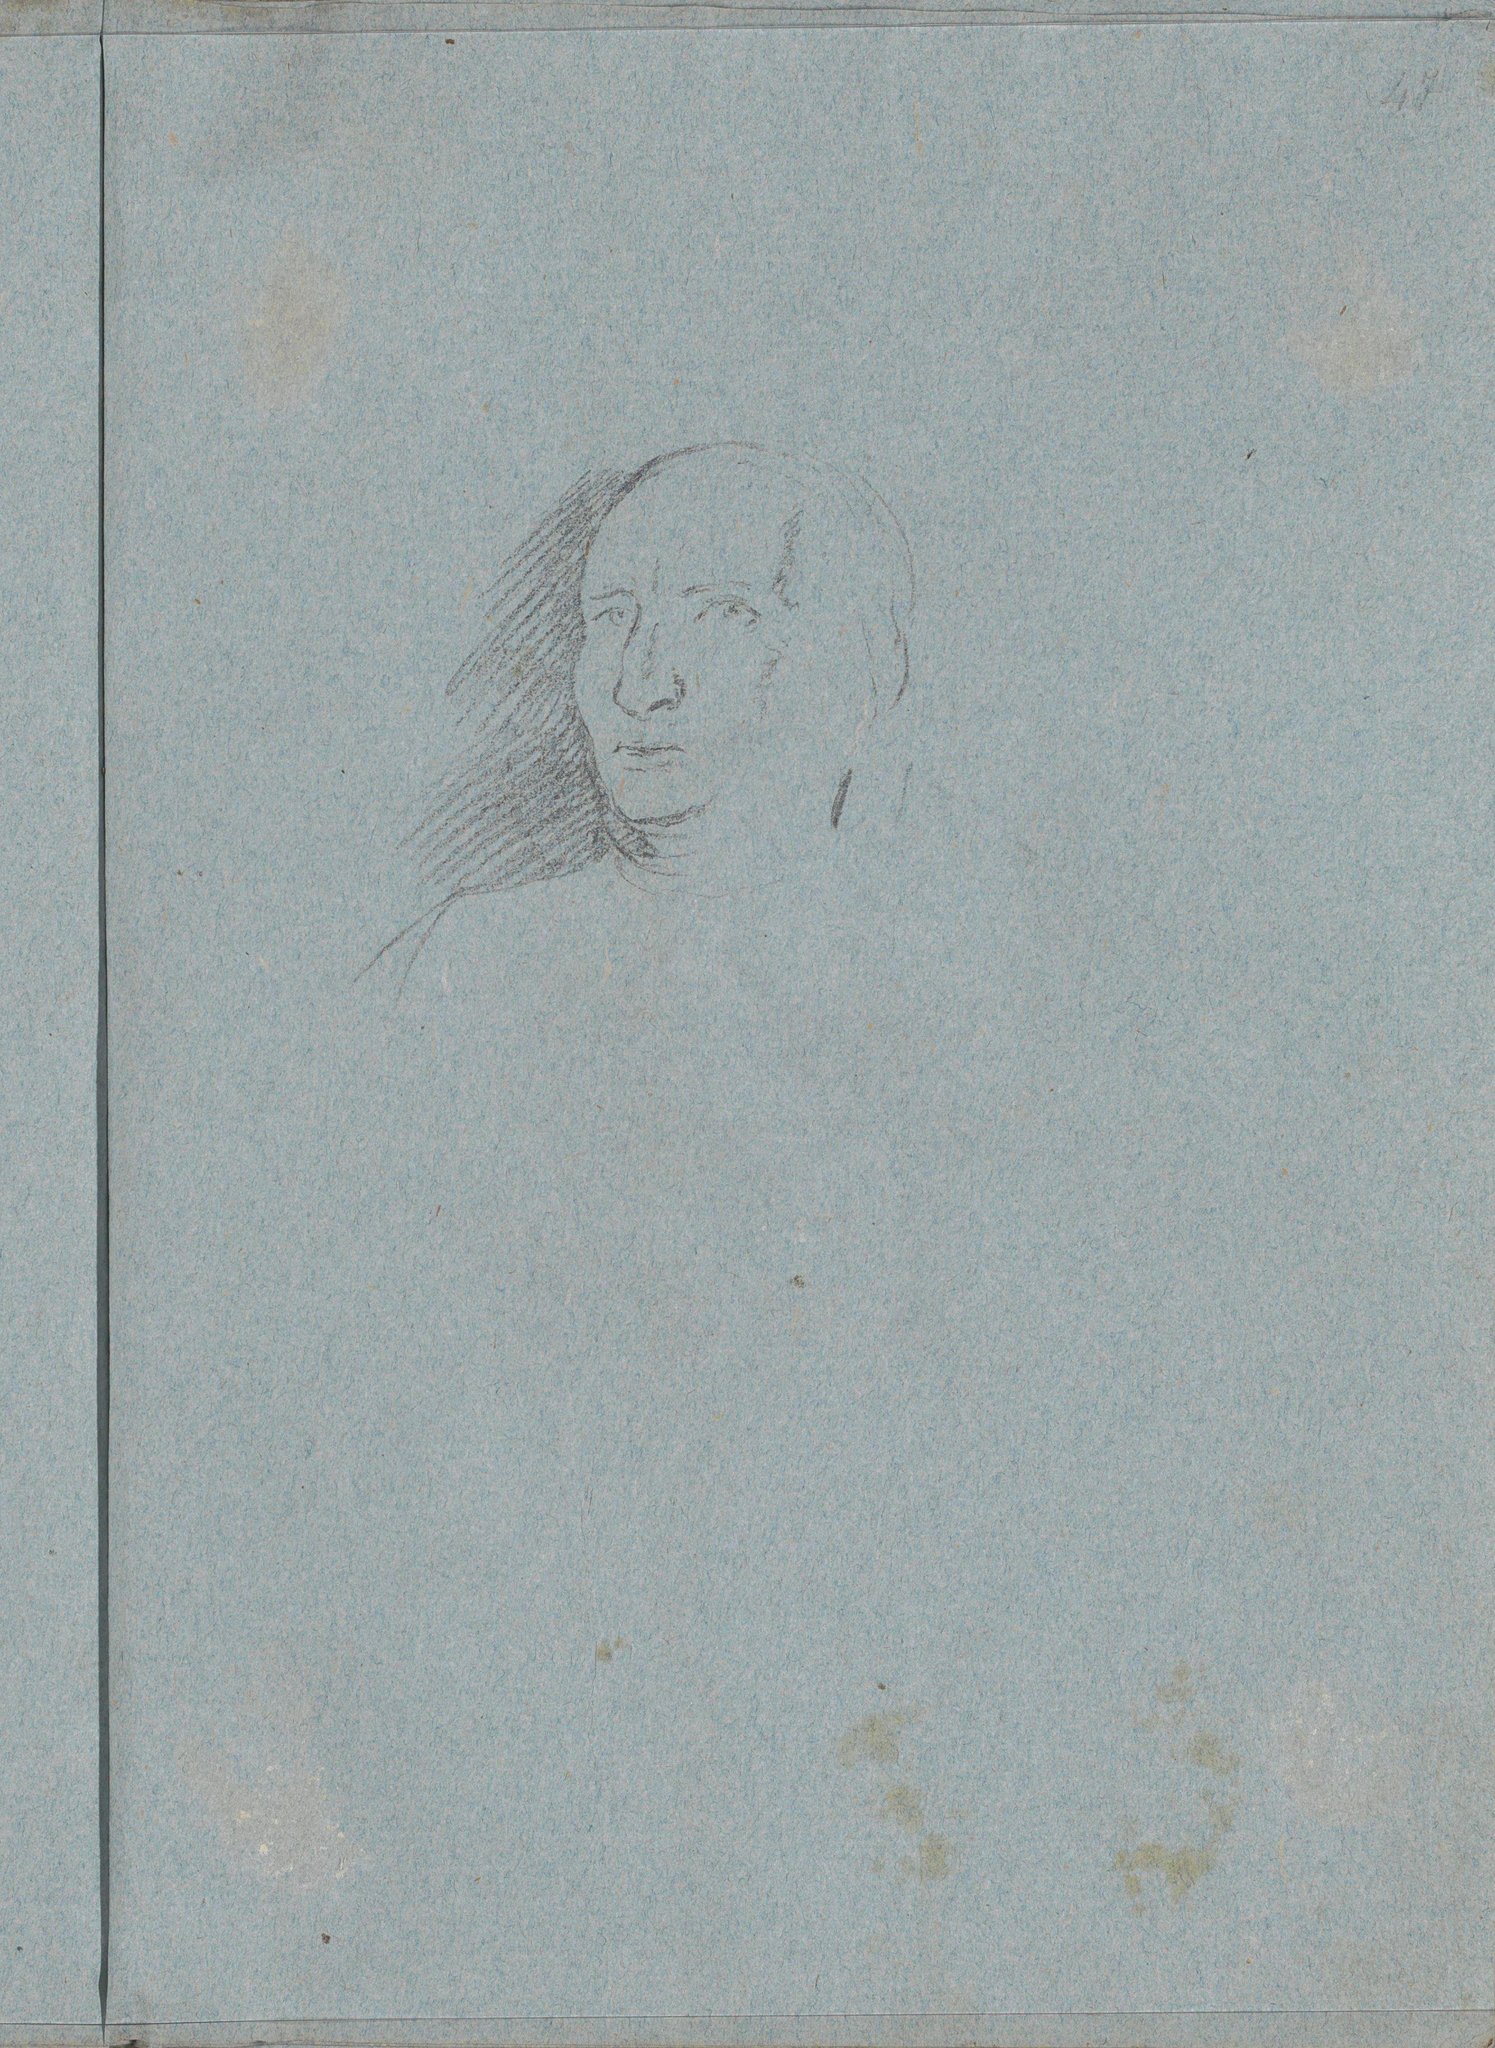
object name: sketchbook leaf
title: Kop van een man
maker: lorenzo baldissera tiepolo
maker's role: draughtsman, print maker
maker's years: 1736-1776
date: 1751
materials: chalk, paper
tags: head (human)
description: Bladzijde 47 uit een schetsboek met 158 bladzijden.